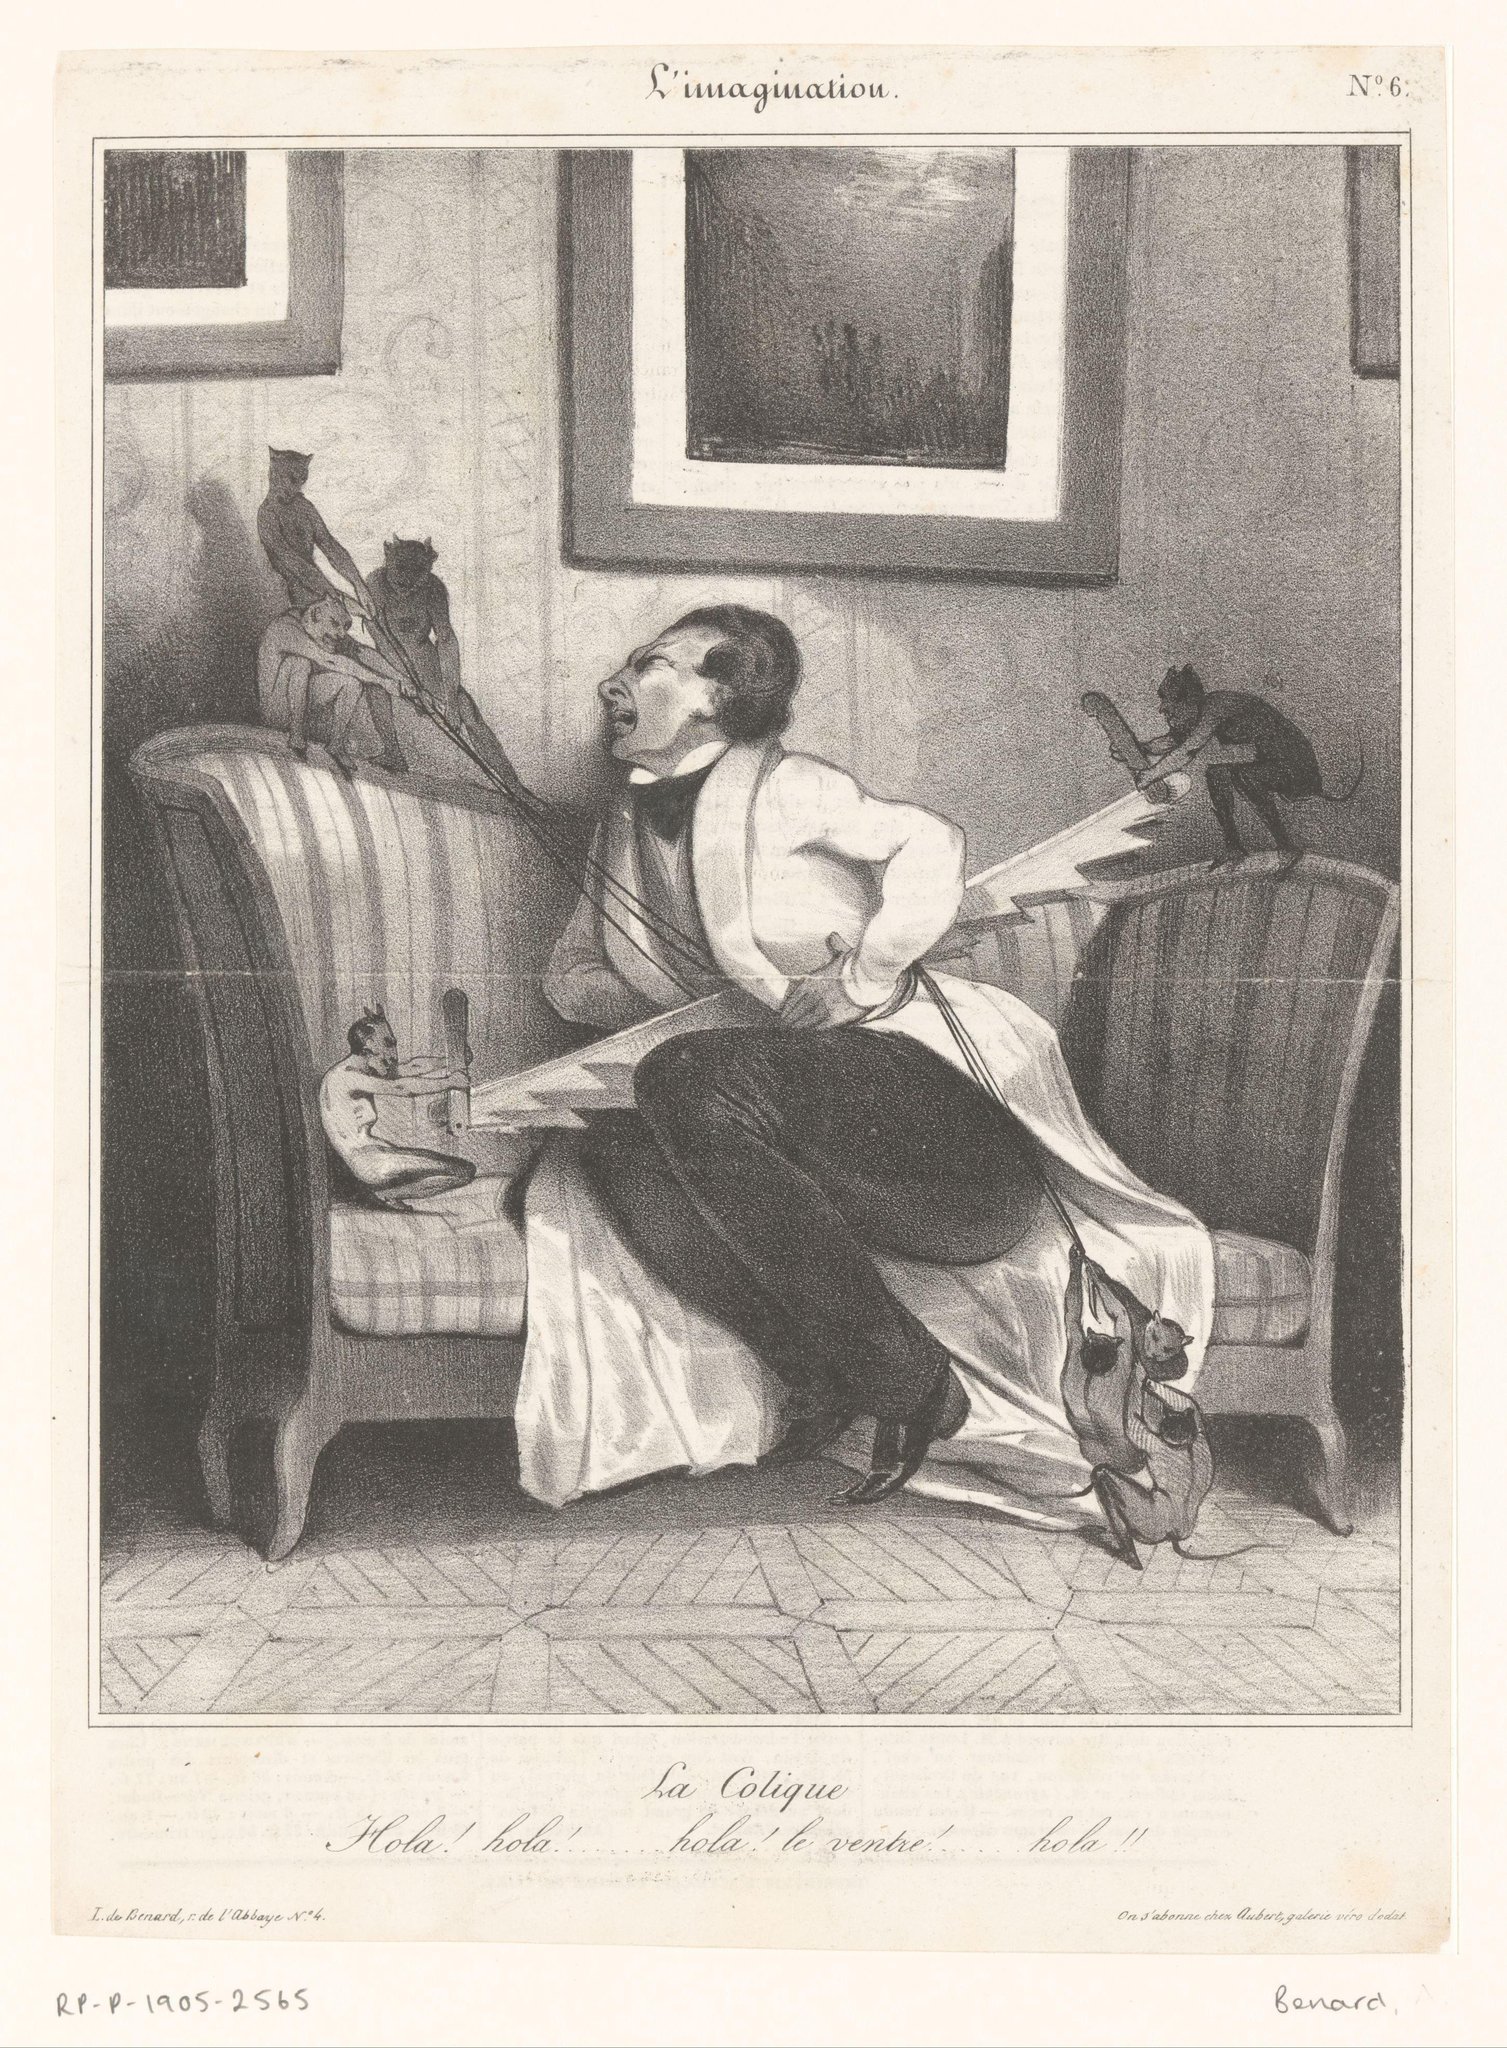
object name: cartoon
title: Karikatuur van een man die lijdt aan koliek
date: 1833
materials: paper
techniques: lithograph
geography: paris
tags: stomach, pain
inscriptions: collector's mark: Lugt 2228a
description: Prent gebruikt voor: Le Charivari, 19 februari 1833.